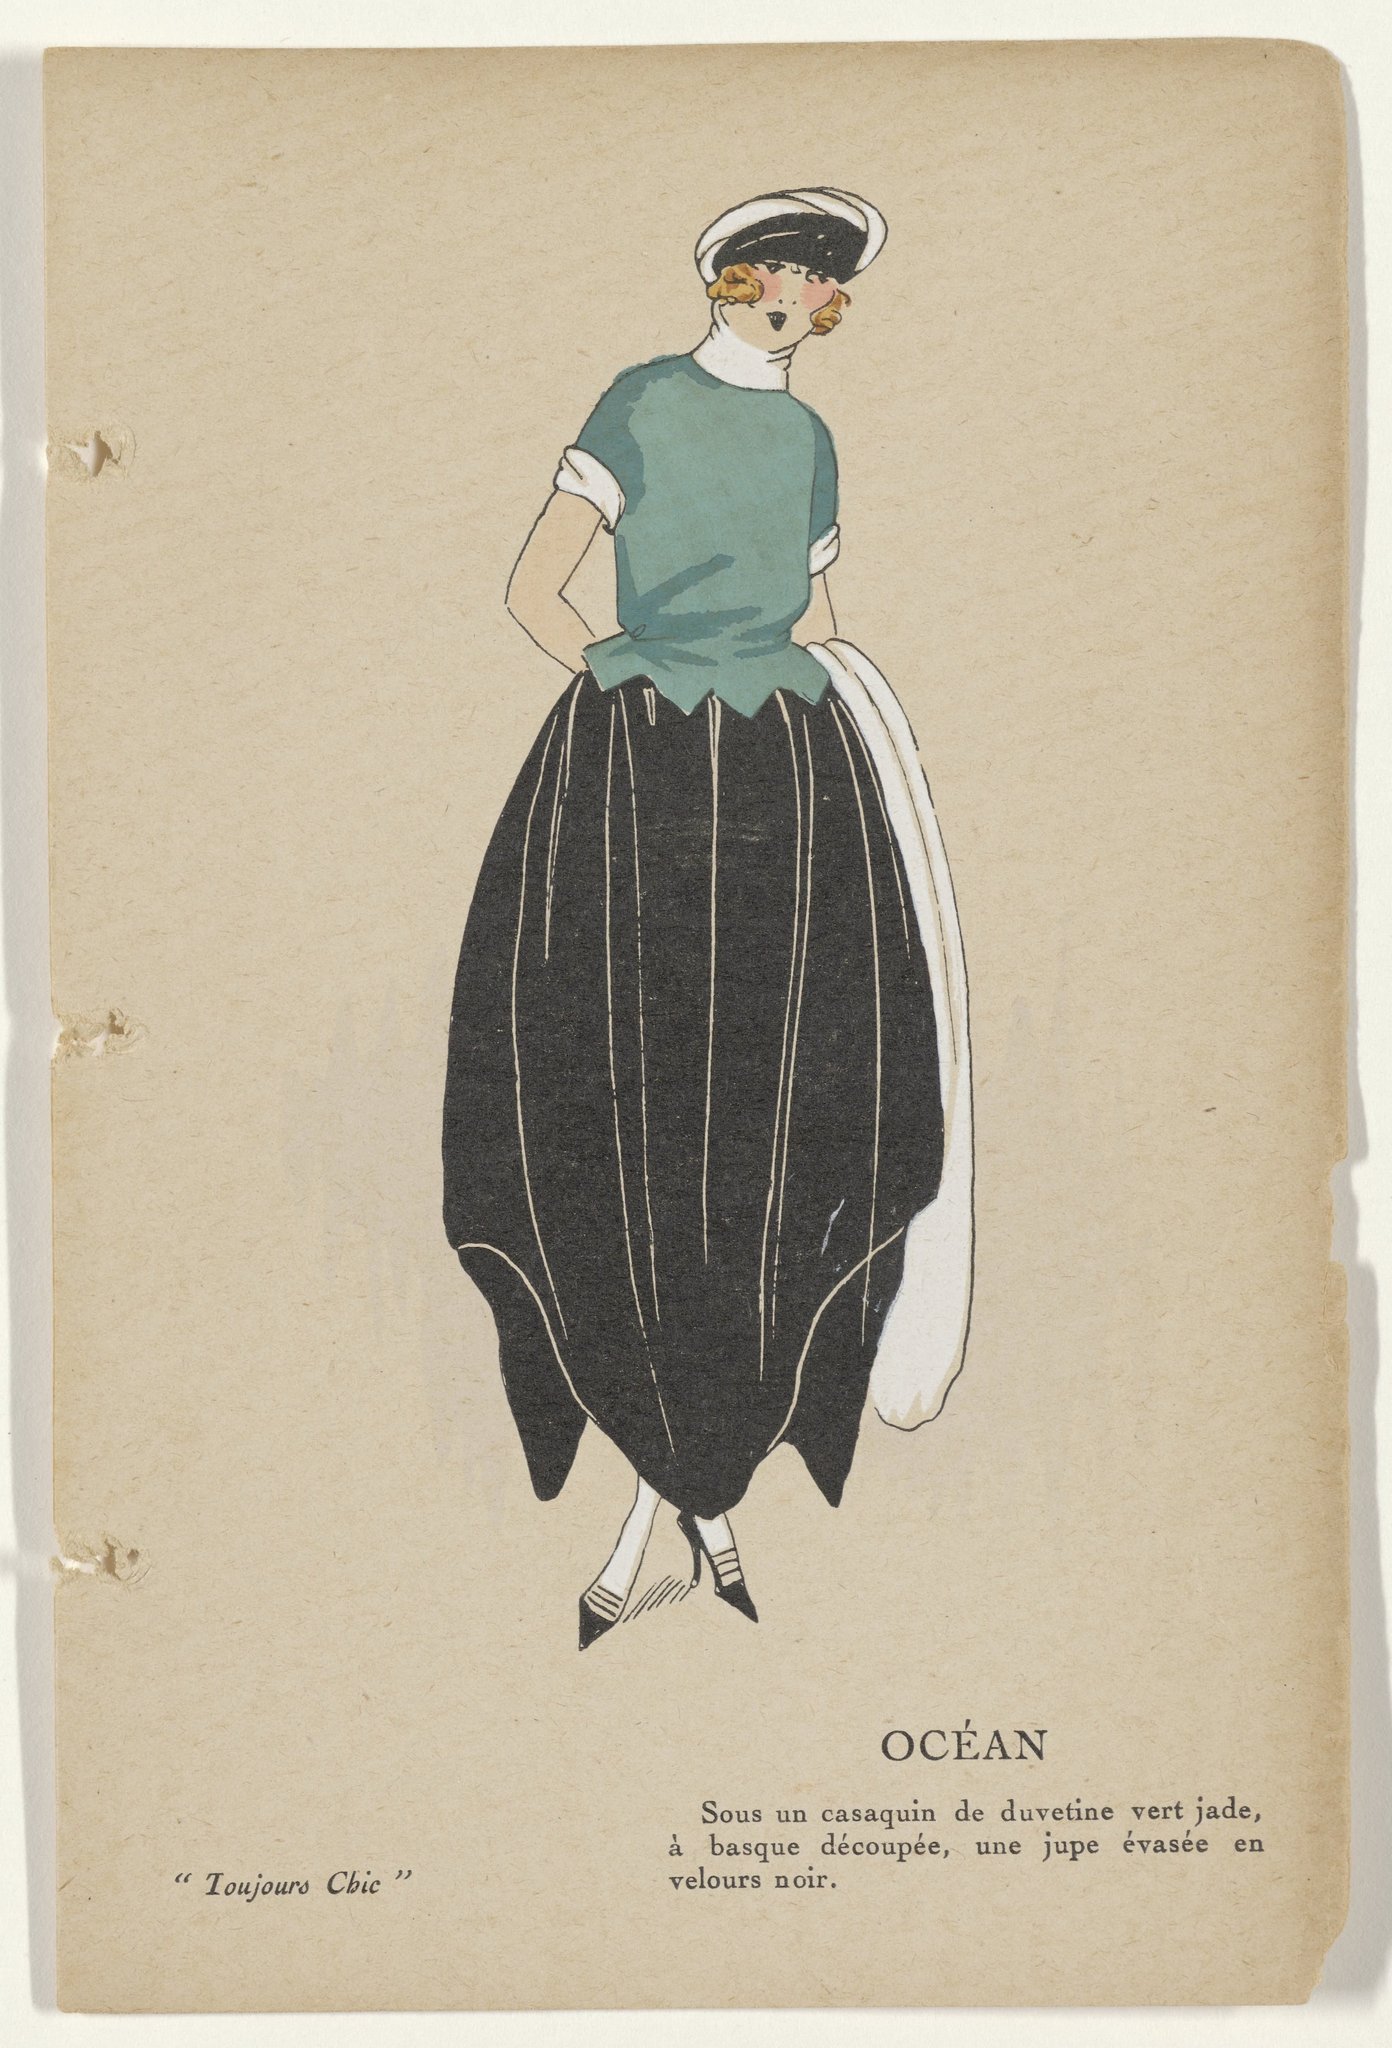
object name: fashion print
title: Toujours Chic Les Robes, Hiver 1921-1922: Océan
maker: g-p. joumard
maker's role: publisher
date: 1921-1922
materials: paper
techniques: letterpress printing, pochoir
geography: paris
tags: fashion plates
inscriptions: date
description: Prent uit Catalogus "Toujours Chic" waarin een overzicht van de wintermode 1921-1922 in 80 prentjes in pochoir techniek.